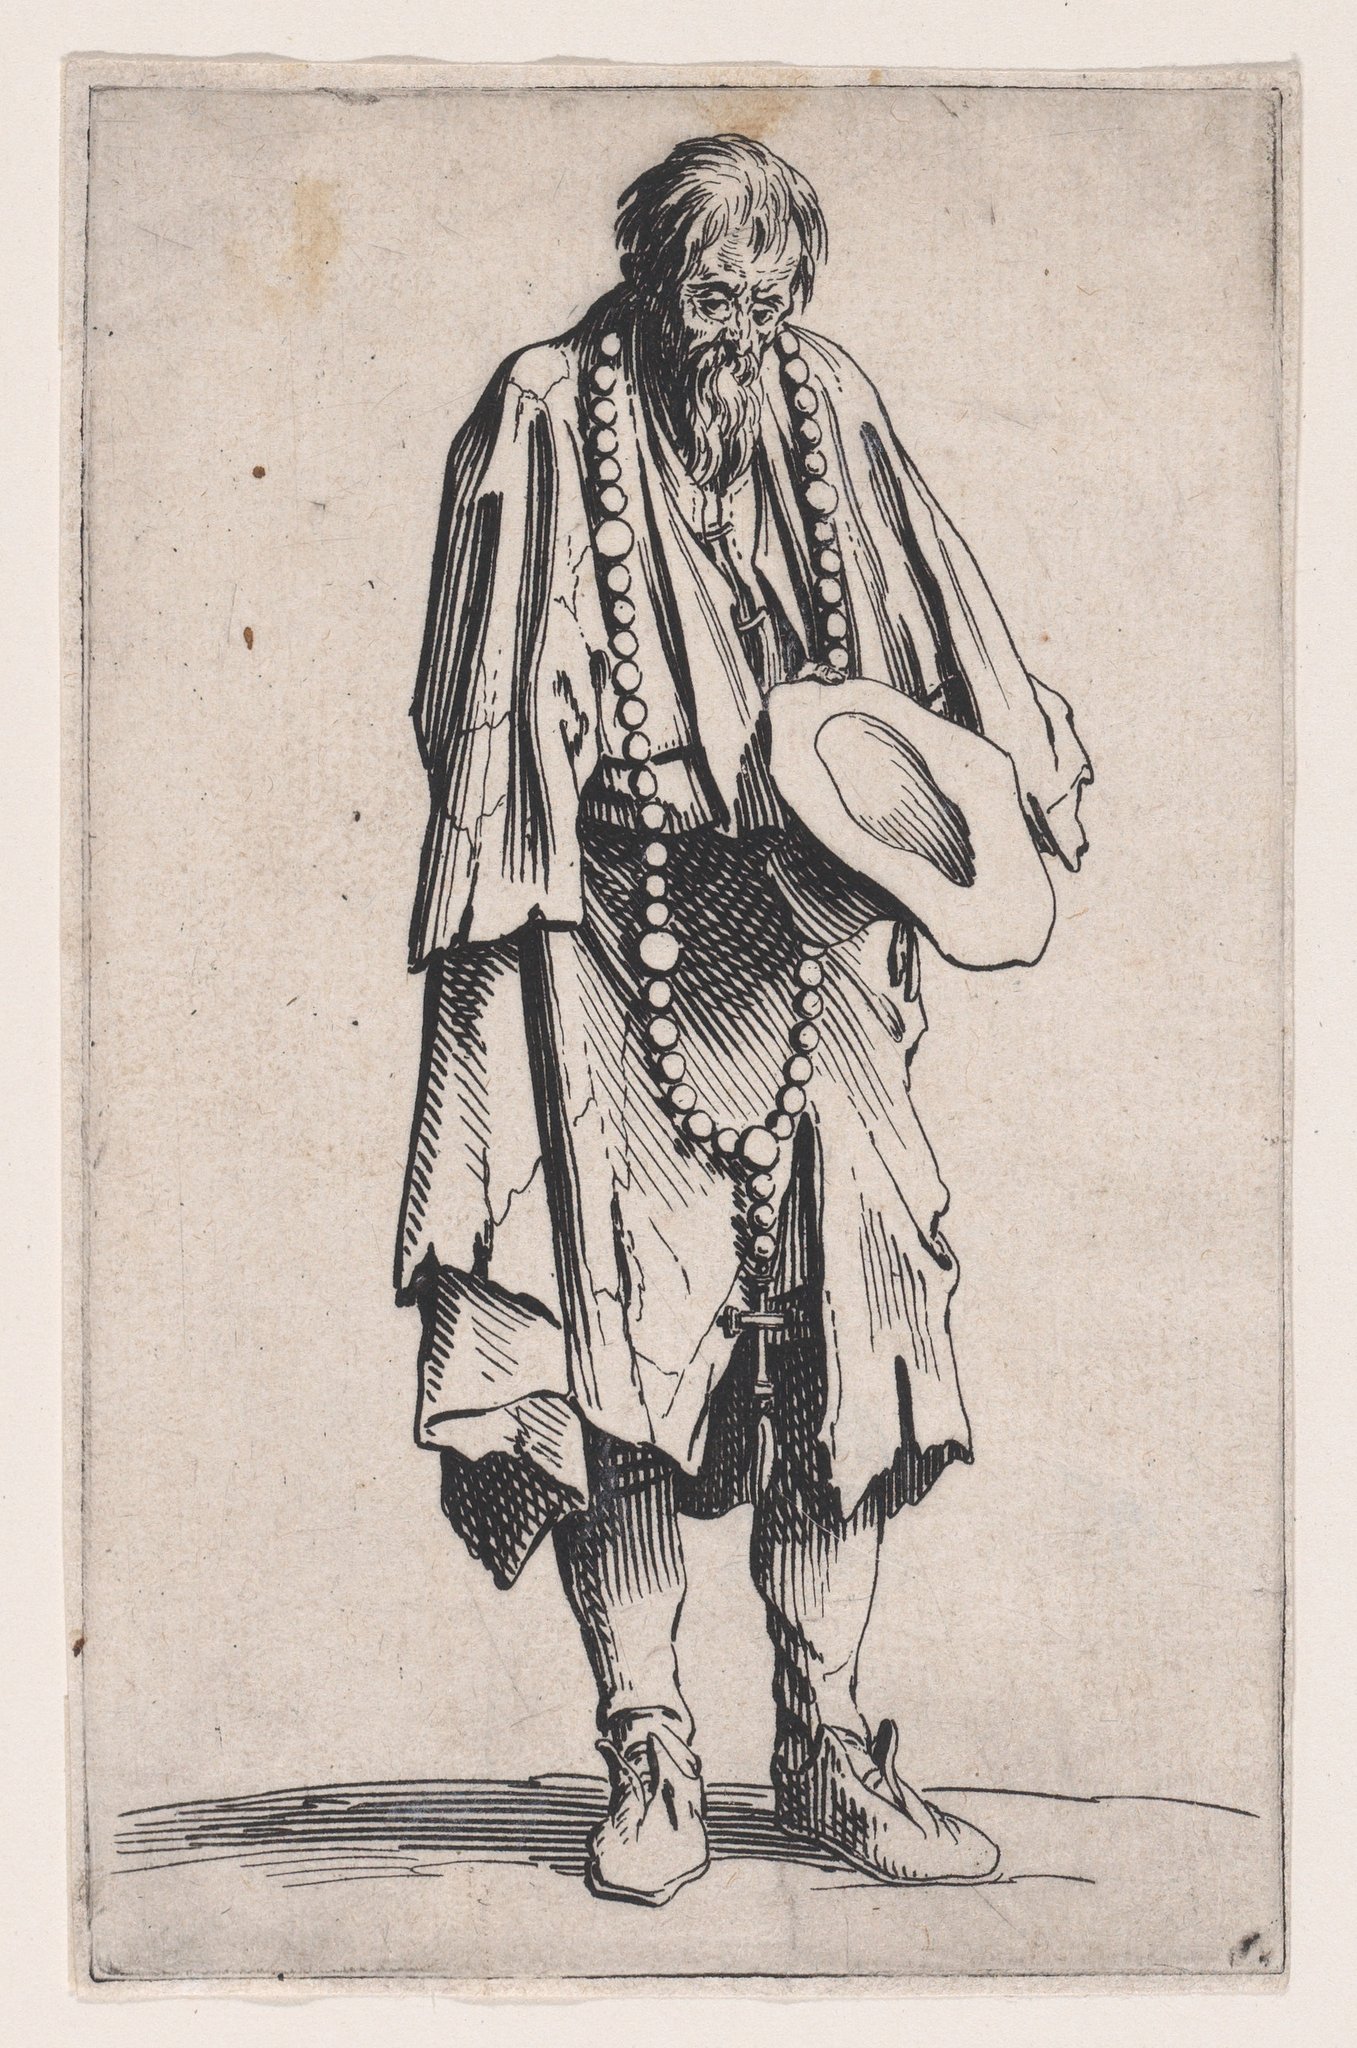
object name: print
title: Le Mendaint au Rosaire (The Beggar with a Rosary), from "Les Gueux suite appelée aussi Les Mendiants, Les Baroni, ou Les Barons" (The Beggars, also called the Barons)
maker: jacques callot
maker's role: artist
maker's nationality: french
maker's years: 1592-1635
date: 1623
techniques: etching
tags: men,rosaries